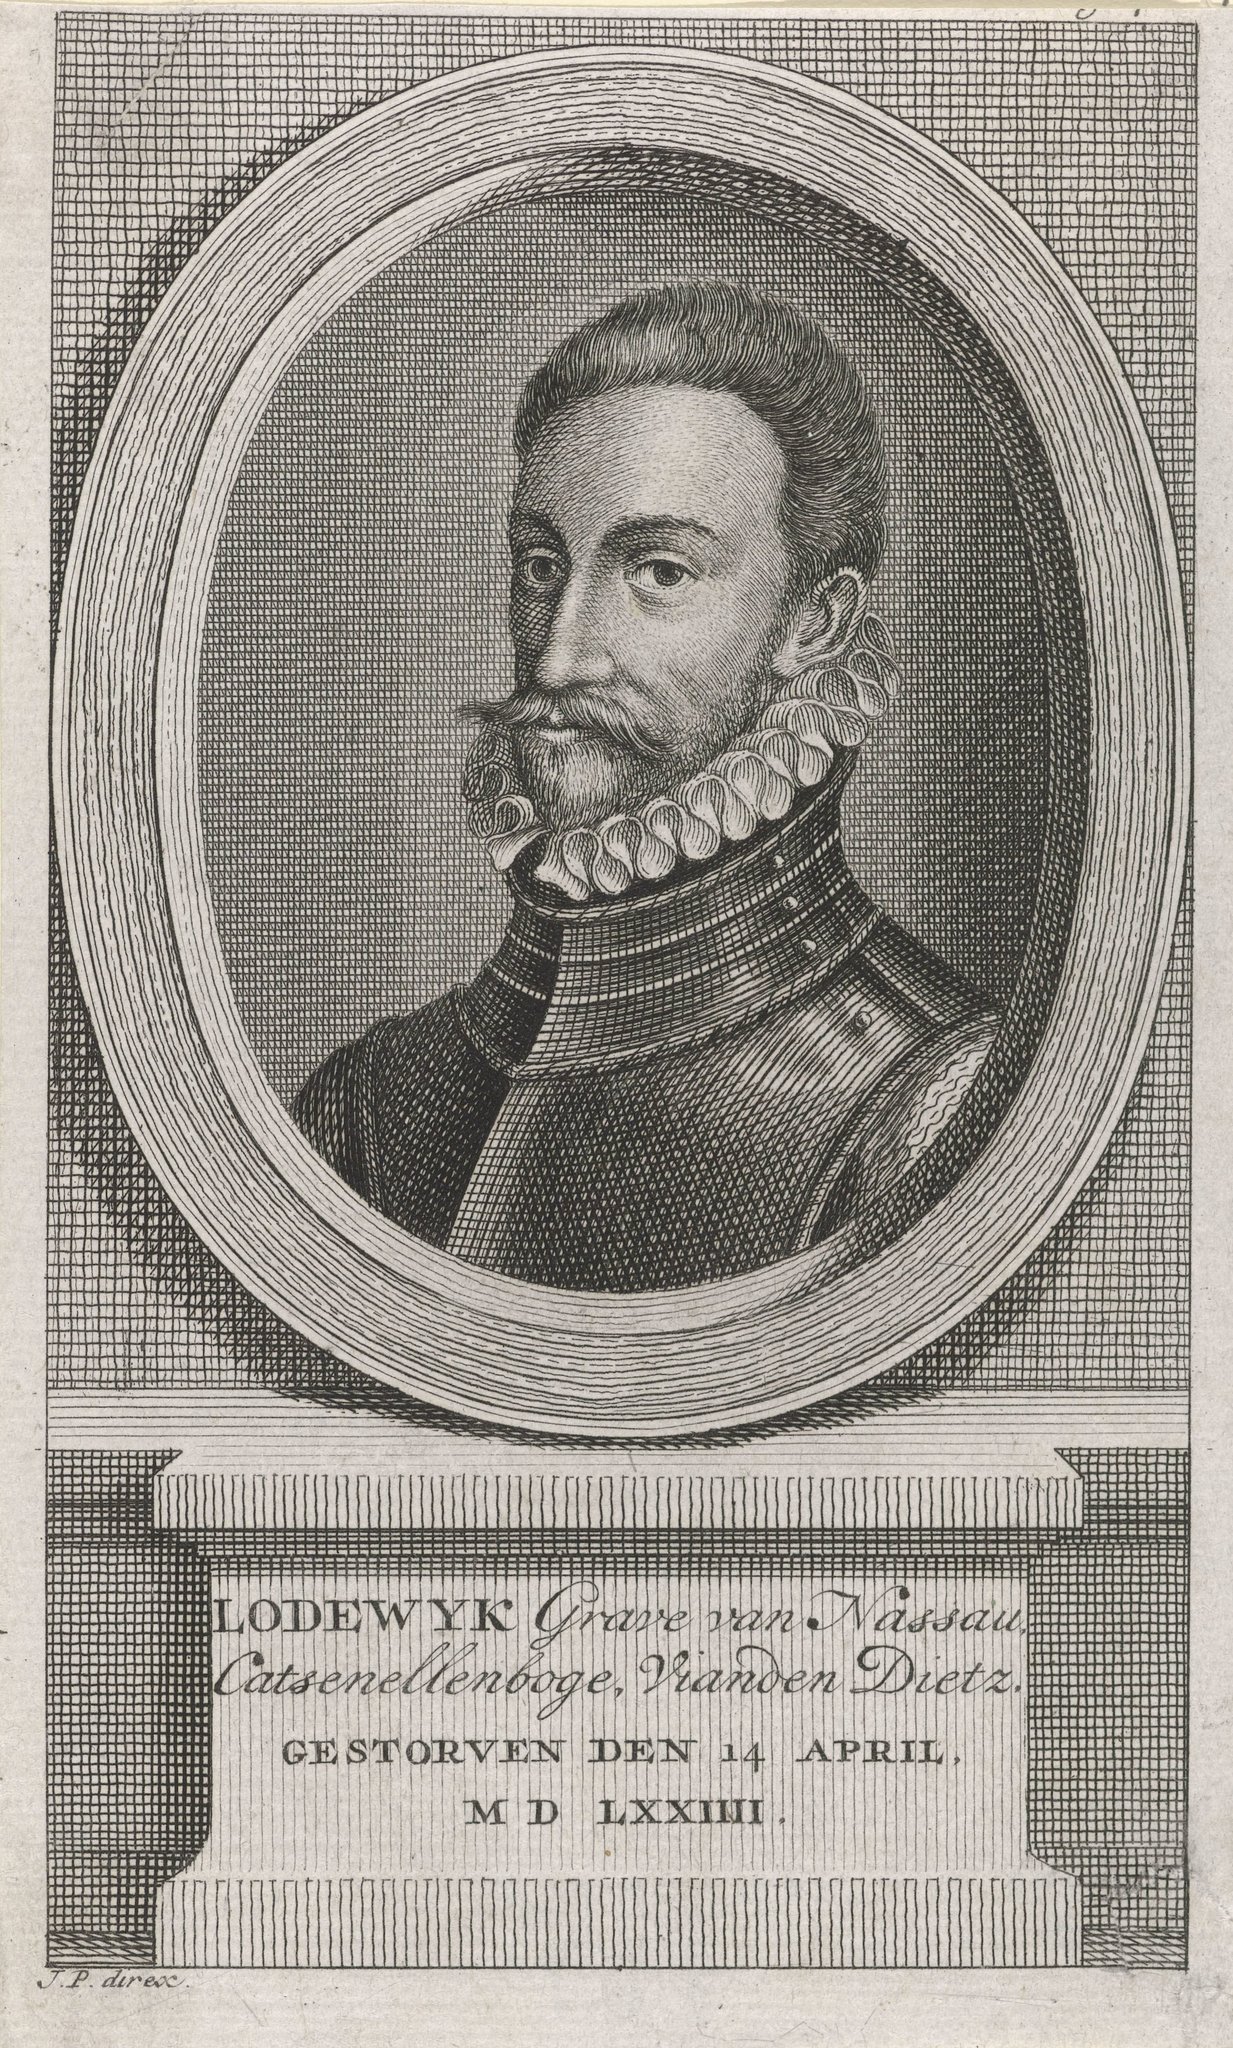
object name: print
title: Portret van Lodewijk, graaf van Nassau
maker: jan punt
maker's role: draughtsman, print maker, publisher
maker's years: 1711-1779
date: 1731-1779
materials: paper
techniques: engraving, etching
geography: northern netherlands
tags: dillenburg, lodewijk graaf van nassau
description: De hier vermelde titel verwijst naar de hoogst verkregen titel van de geportretteerde, niet per se naar de titel die de geportretteerde op deze voorstelling draagt.